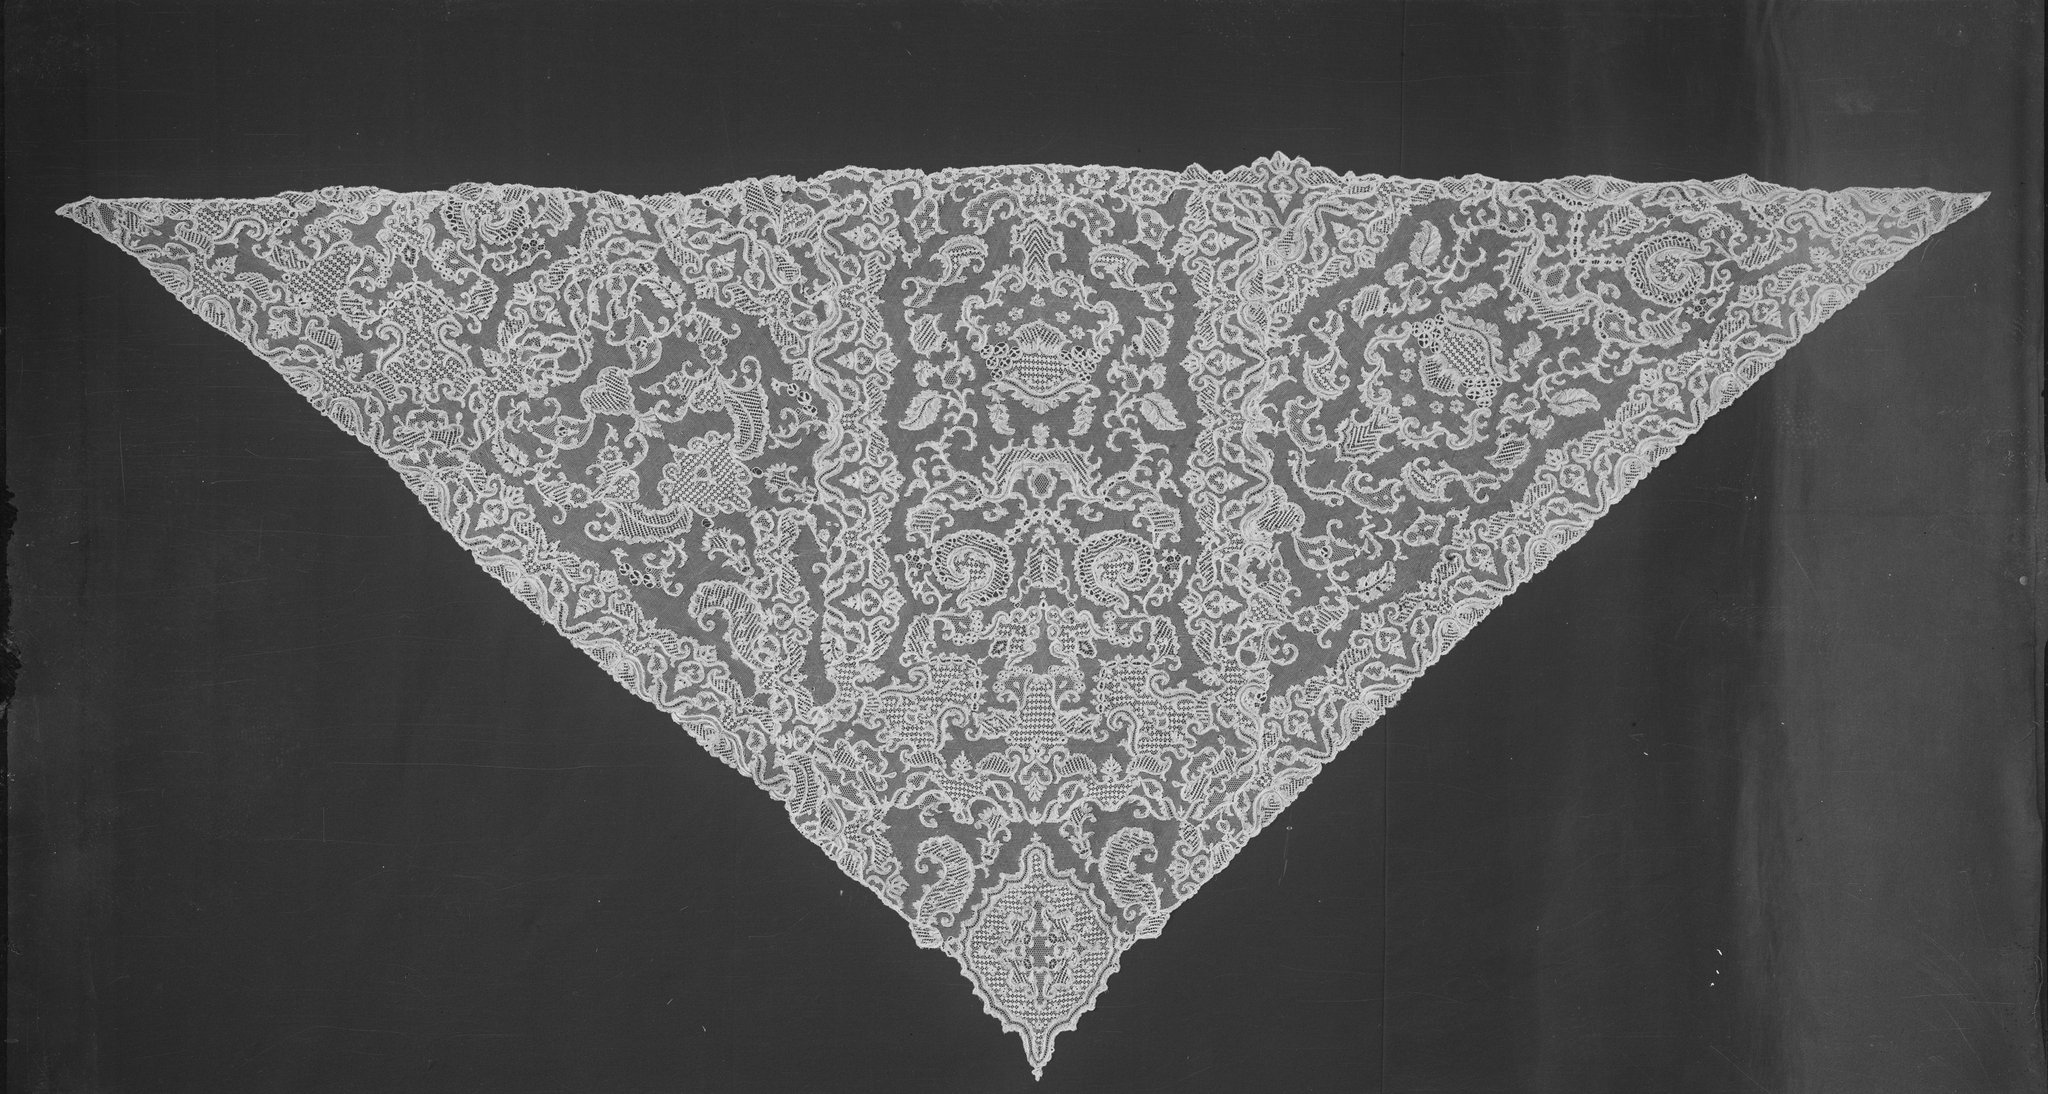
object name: shawl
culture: british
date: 1801-1900